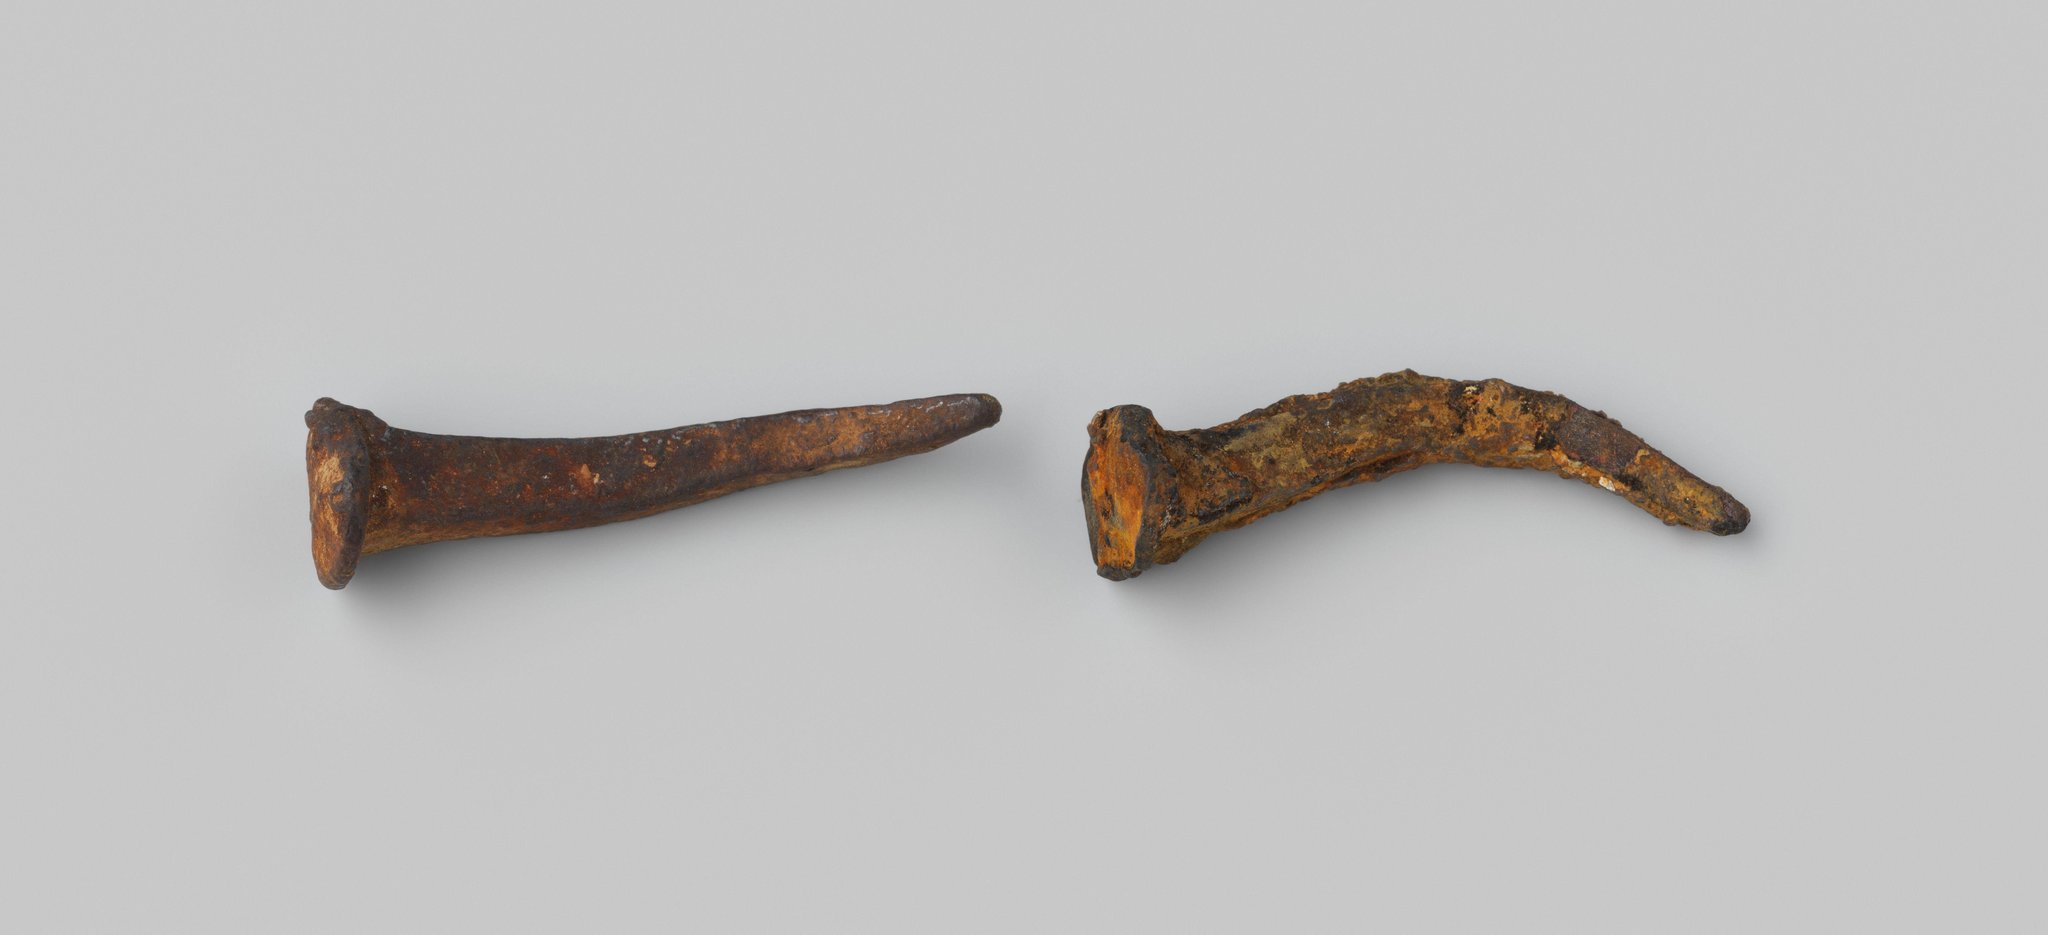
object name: nagel, spijker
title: Spijkers afkomstig uit het wrak van de Oost-Indiëvaarder Hollandia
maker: Anonymous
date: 1700-1743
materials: iron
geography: netherlands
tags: verenigde oostindische compagnie, hollandia (schip)